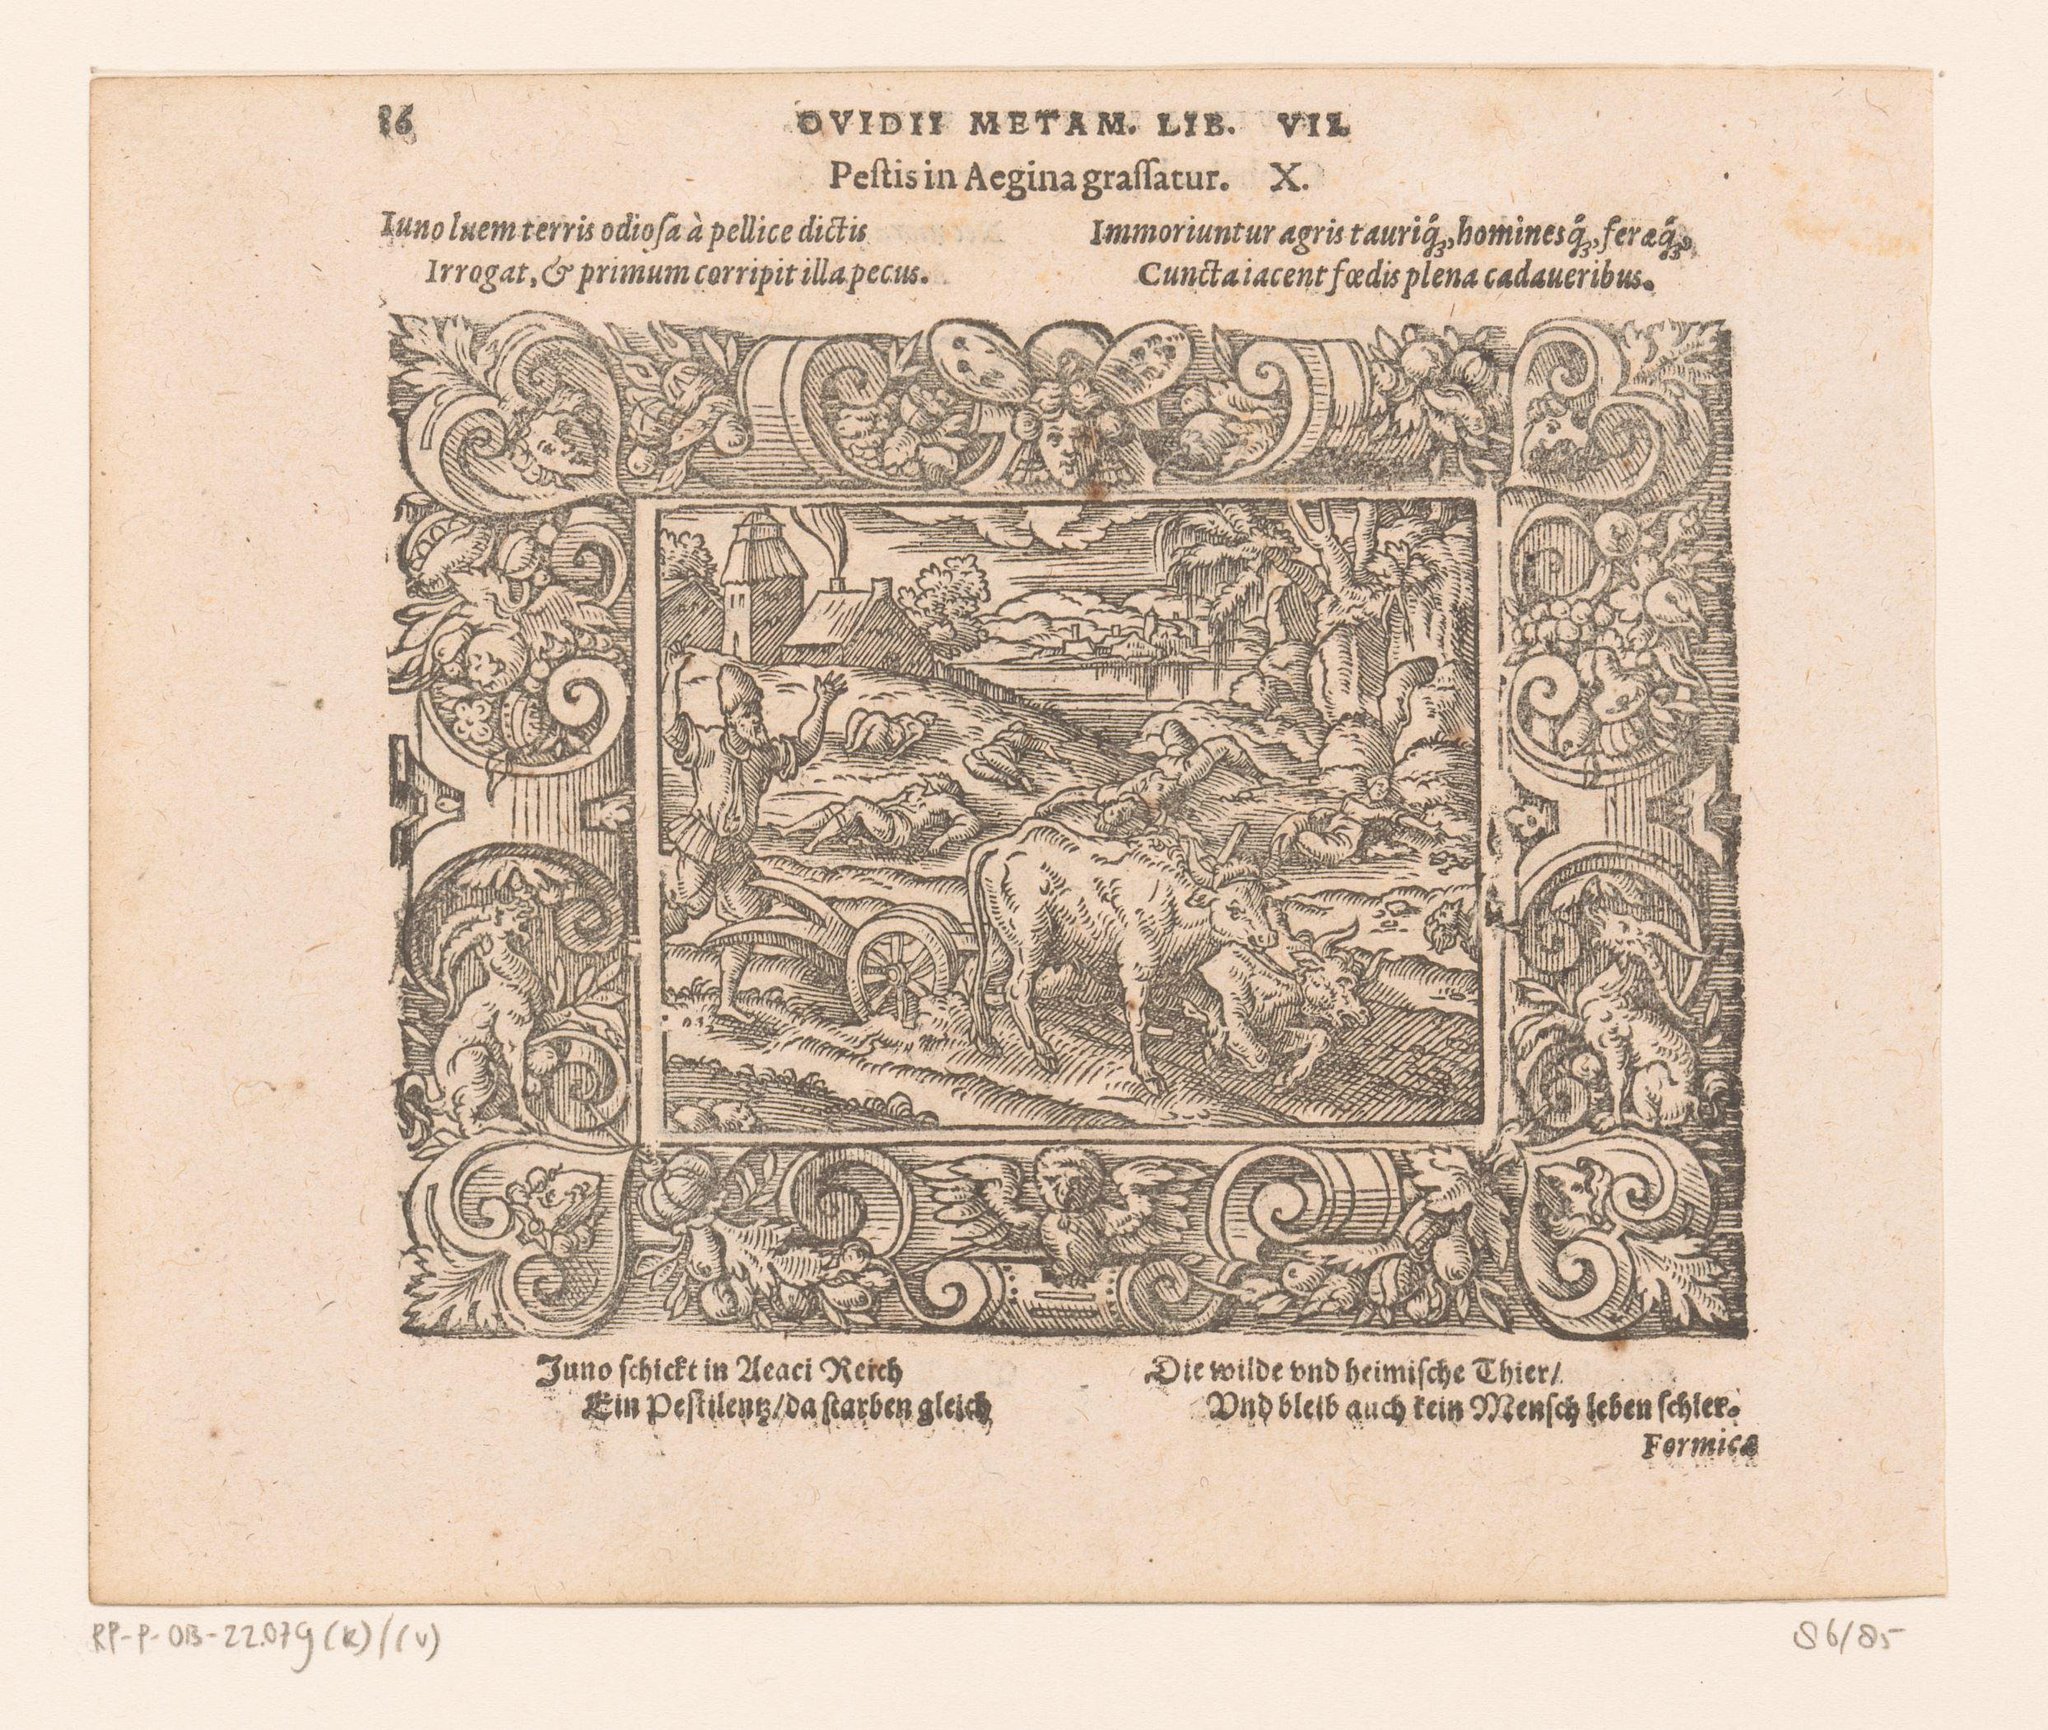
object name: book illustration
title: Pestis in Aegina grassatur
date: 1569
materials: paper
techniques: letterpress printing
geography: frankfurt am main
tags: the island of aegina is stricken with pestilence, scrollwork, strapwork ~ ornament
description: Illustratie bij de Metamorfosen van Ovidius, afkomstig uit de publicatie: Posthius, Johannes. Tetrasticha in Ovidii metam. Frankfurt am Main: Georg Rab en Sigmund Feyerabend en erven Weigand Han, 1569. De voorstellingen en ornamentranden van deze boekillustraties zijn van twee aparte blokken gedrukt. Beide werden afzonderlijk van elkaar ook gebruikt voor andere publicaties, en de ornamentranden werden eveneens binnen deze publicatie meerdere keren gebruikt.